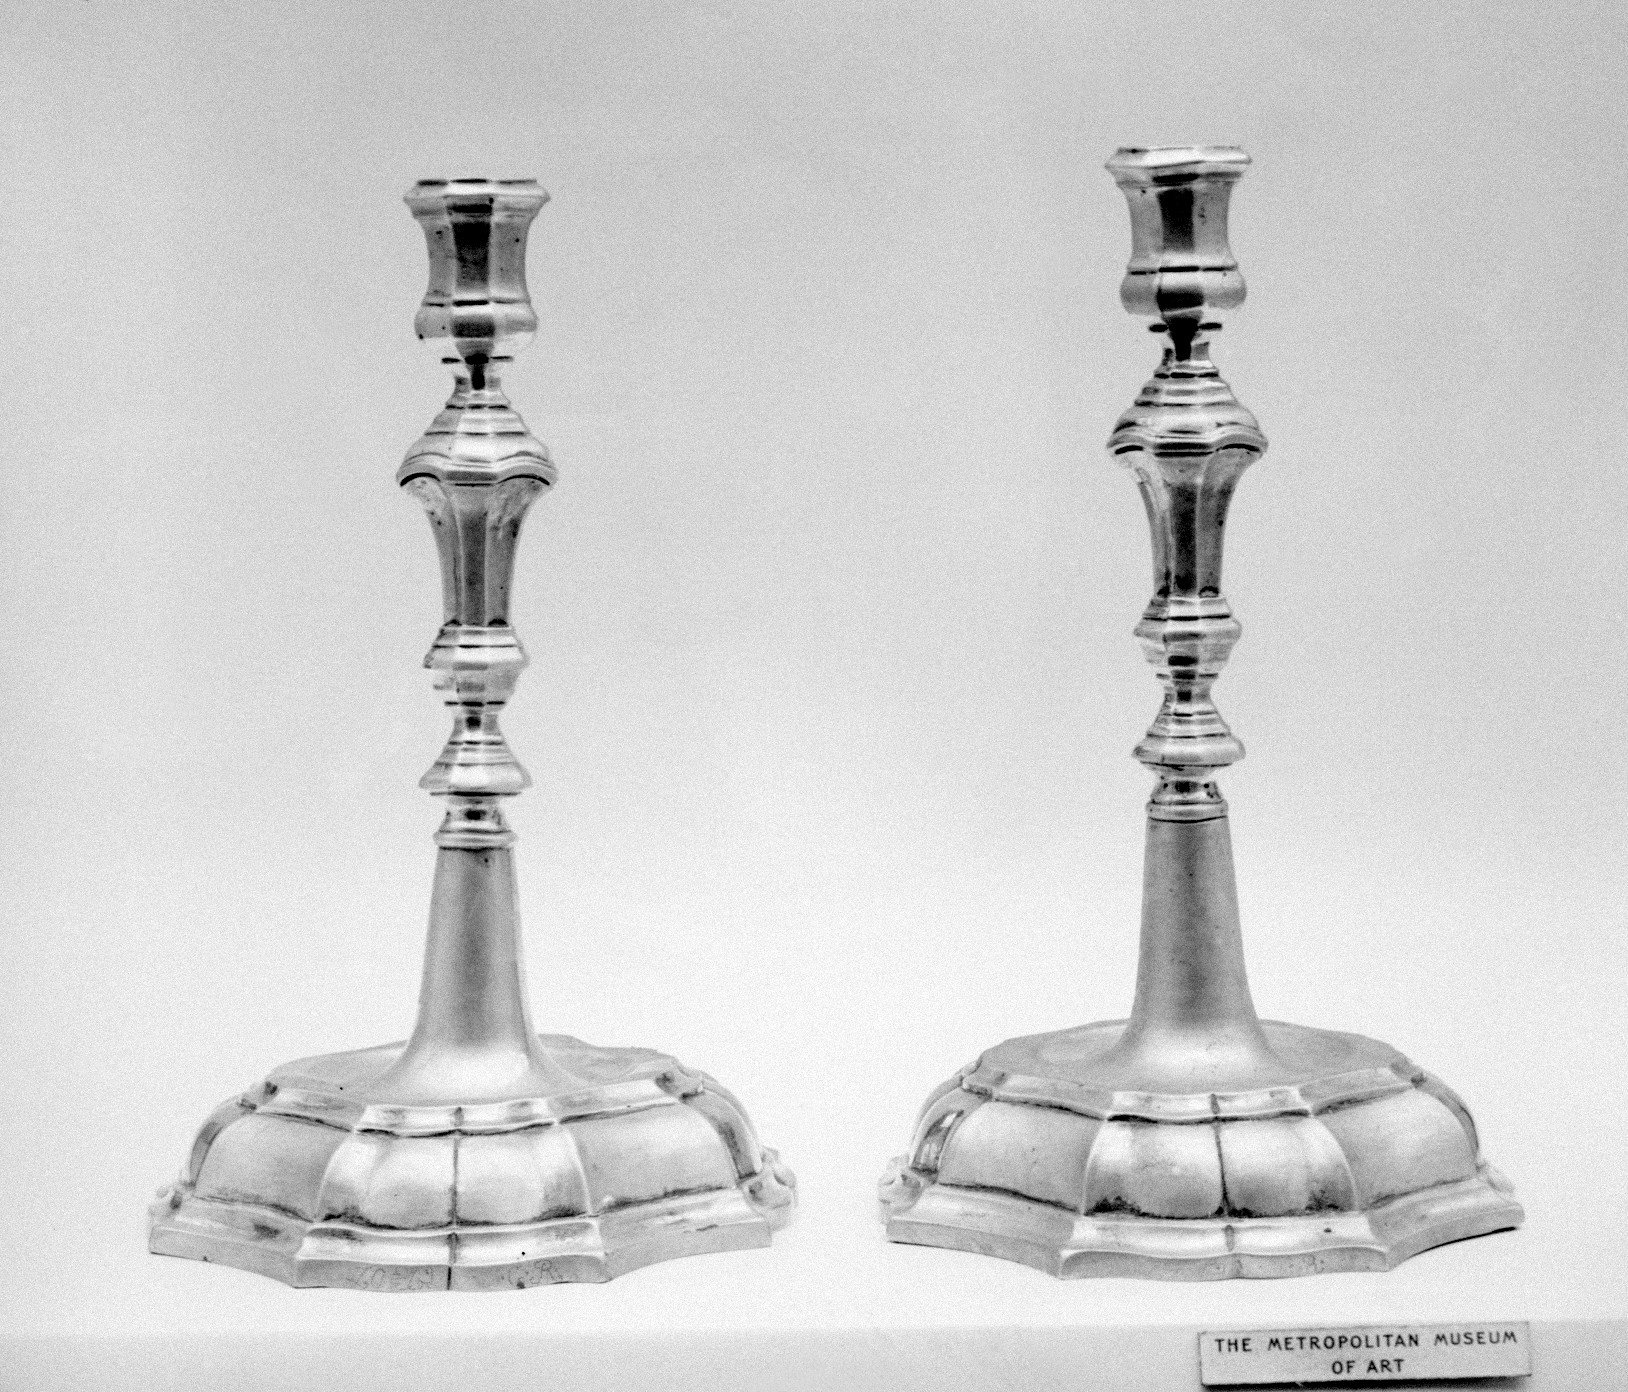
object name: candlestick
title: Candlestick (one of a pair)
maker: johan jorgen schowert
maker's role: maker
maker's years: 1738-1755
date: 1701-1800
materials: silver